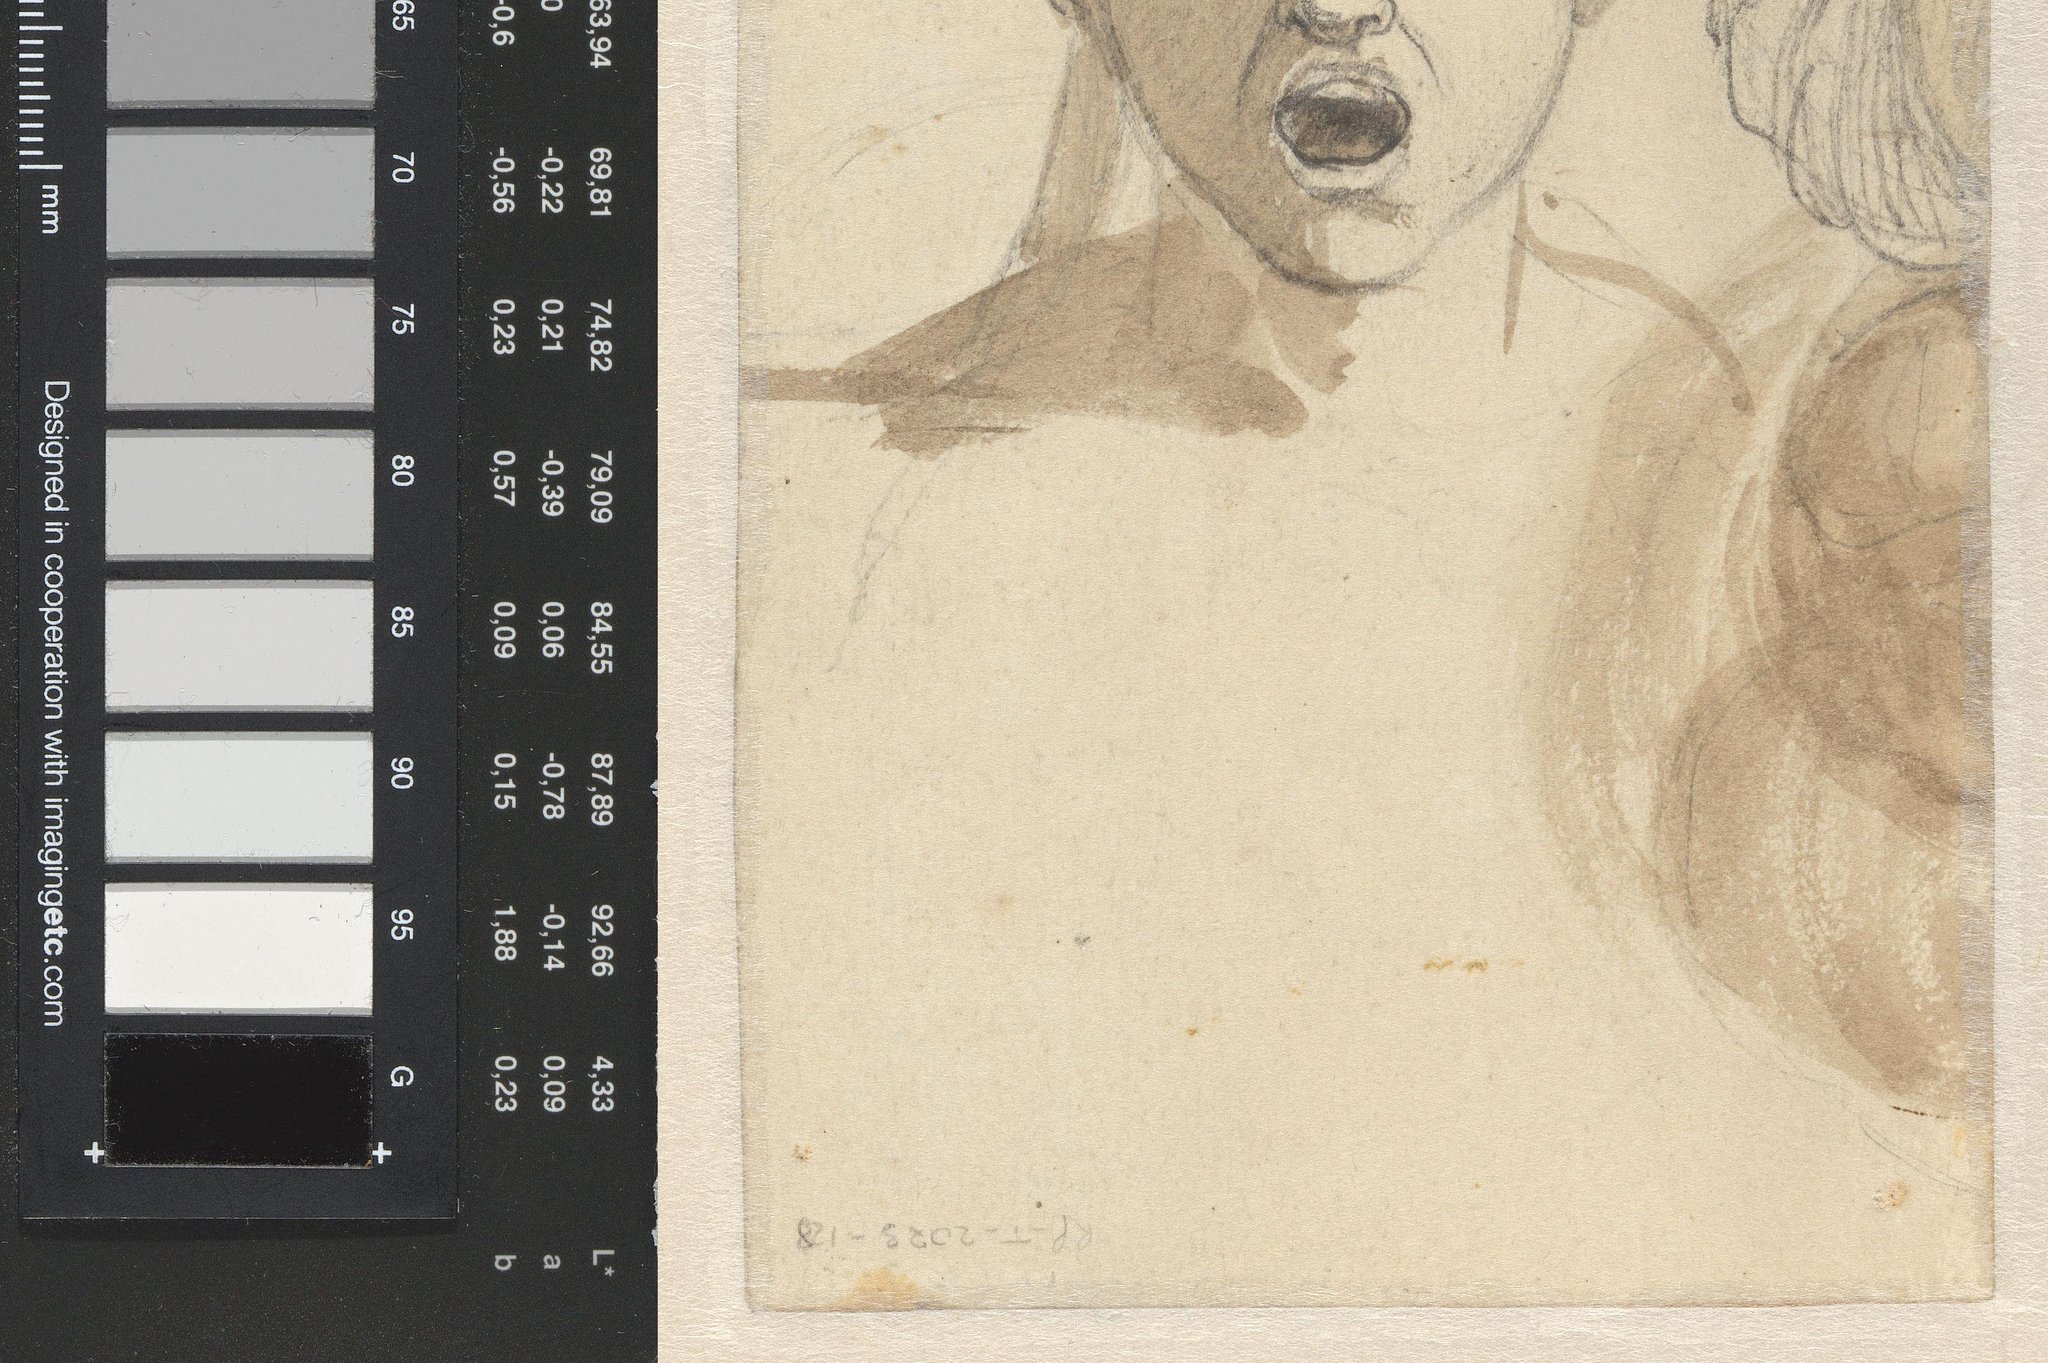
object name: drawing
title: Hoofd met open mond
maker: joannes carolus alberdingk thijm (jan)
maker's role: pater, schrijver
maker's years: 1847-1926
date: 1853-1860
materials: ink, paper, pencil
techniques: brush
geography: netherlands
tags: mouth wide open, face